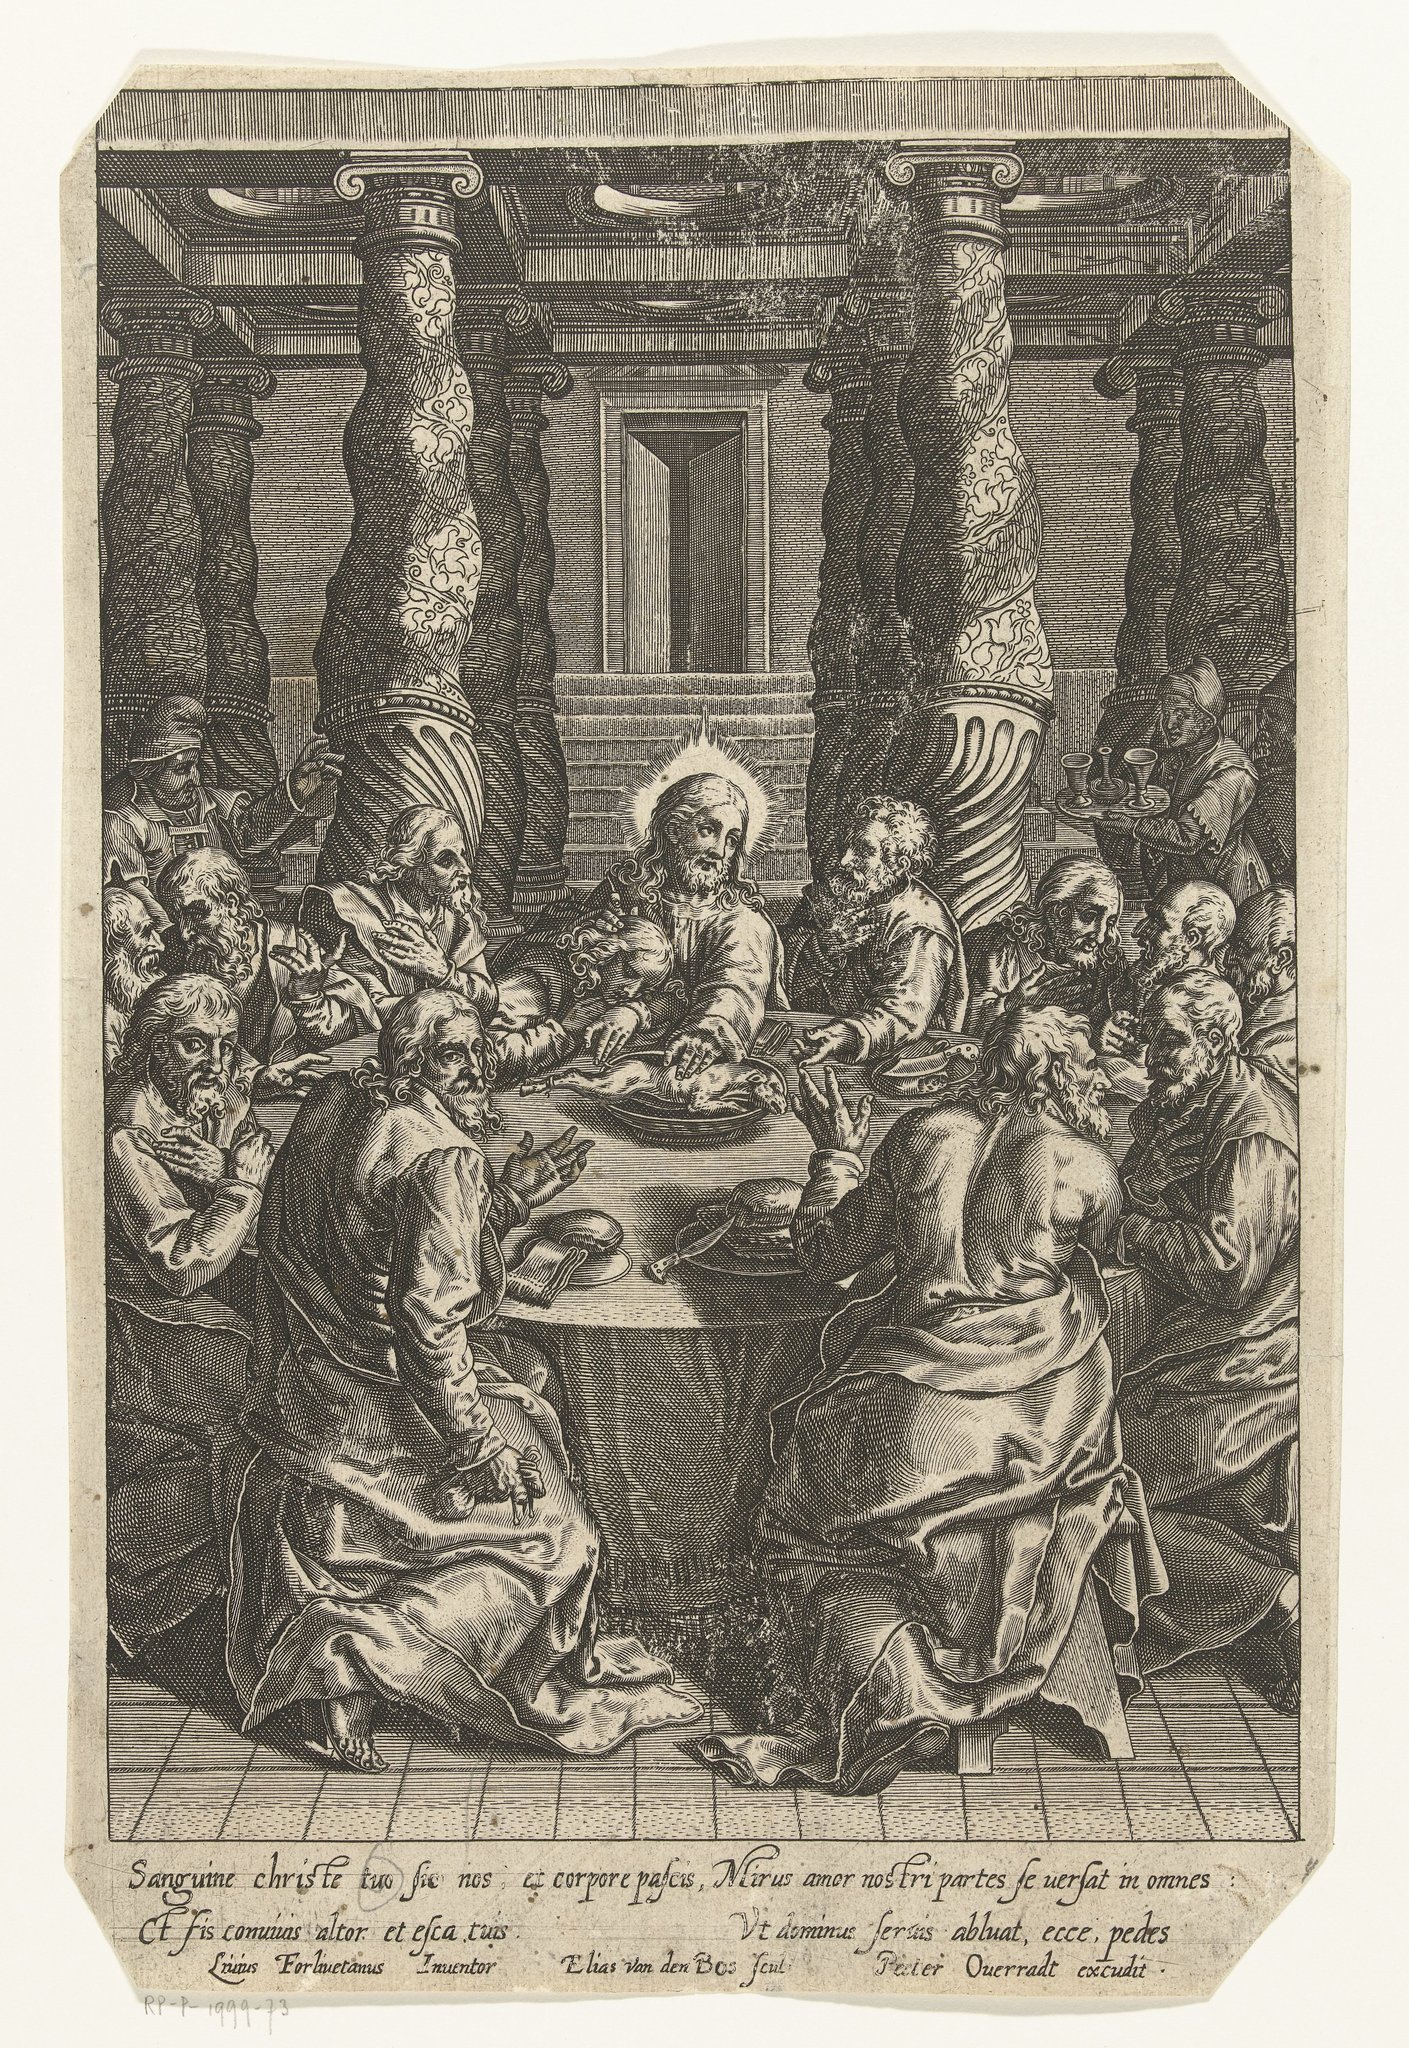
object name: print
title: Laatste Avondmaal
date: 1600-1620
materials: paper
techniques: engraving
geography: cologne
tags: last supper (in general) (matthew 26:21-35; mark 14:18-31; luke 22:3, 22:15-23; john 13:21-38)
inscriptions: collector's mark: Lugt 2228, collector's mark: Lugt 2760, inscription: ‘Sanguine christe tuo...abluat, ecce, pedes.’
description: Laatste Avondmaal: Christus zit in het midden en legt zijn linkerhand op het geslachte lam dat op een schaal op de tafel ligt. Met zijn rechterarm omarmt hij Johannes die tegen zijn borst leunt. De rest van de apostelen discussiërend om de tafel. Links voor Judas met geldbuidel in de hand. Rechtsachter een bediende.